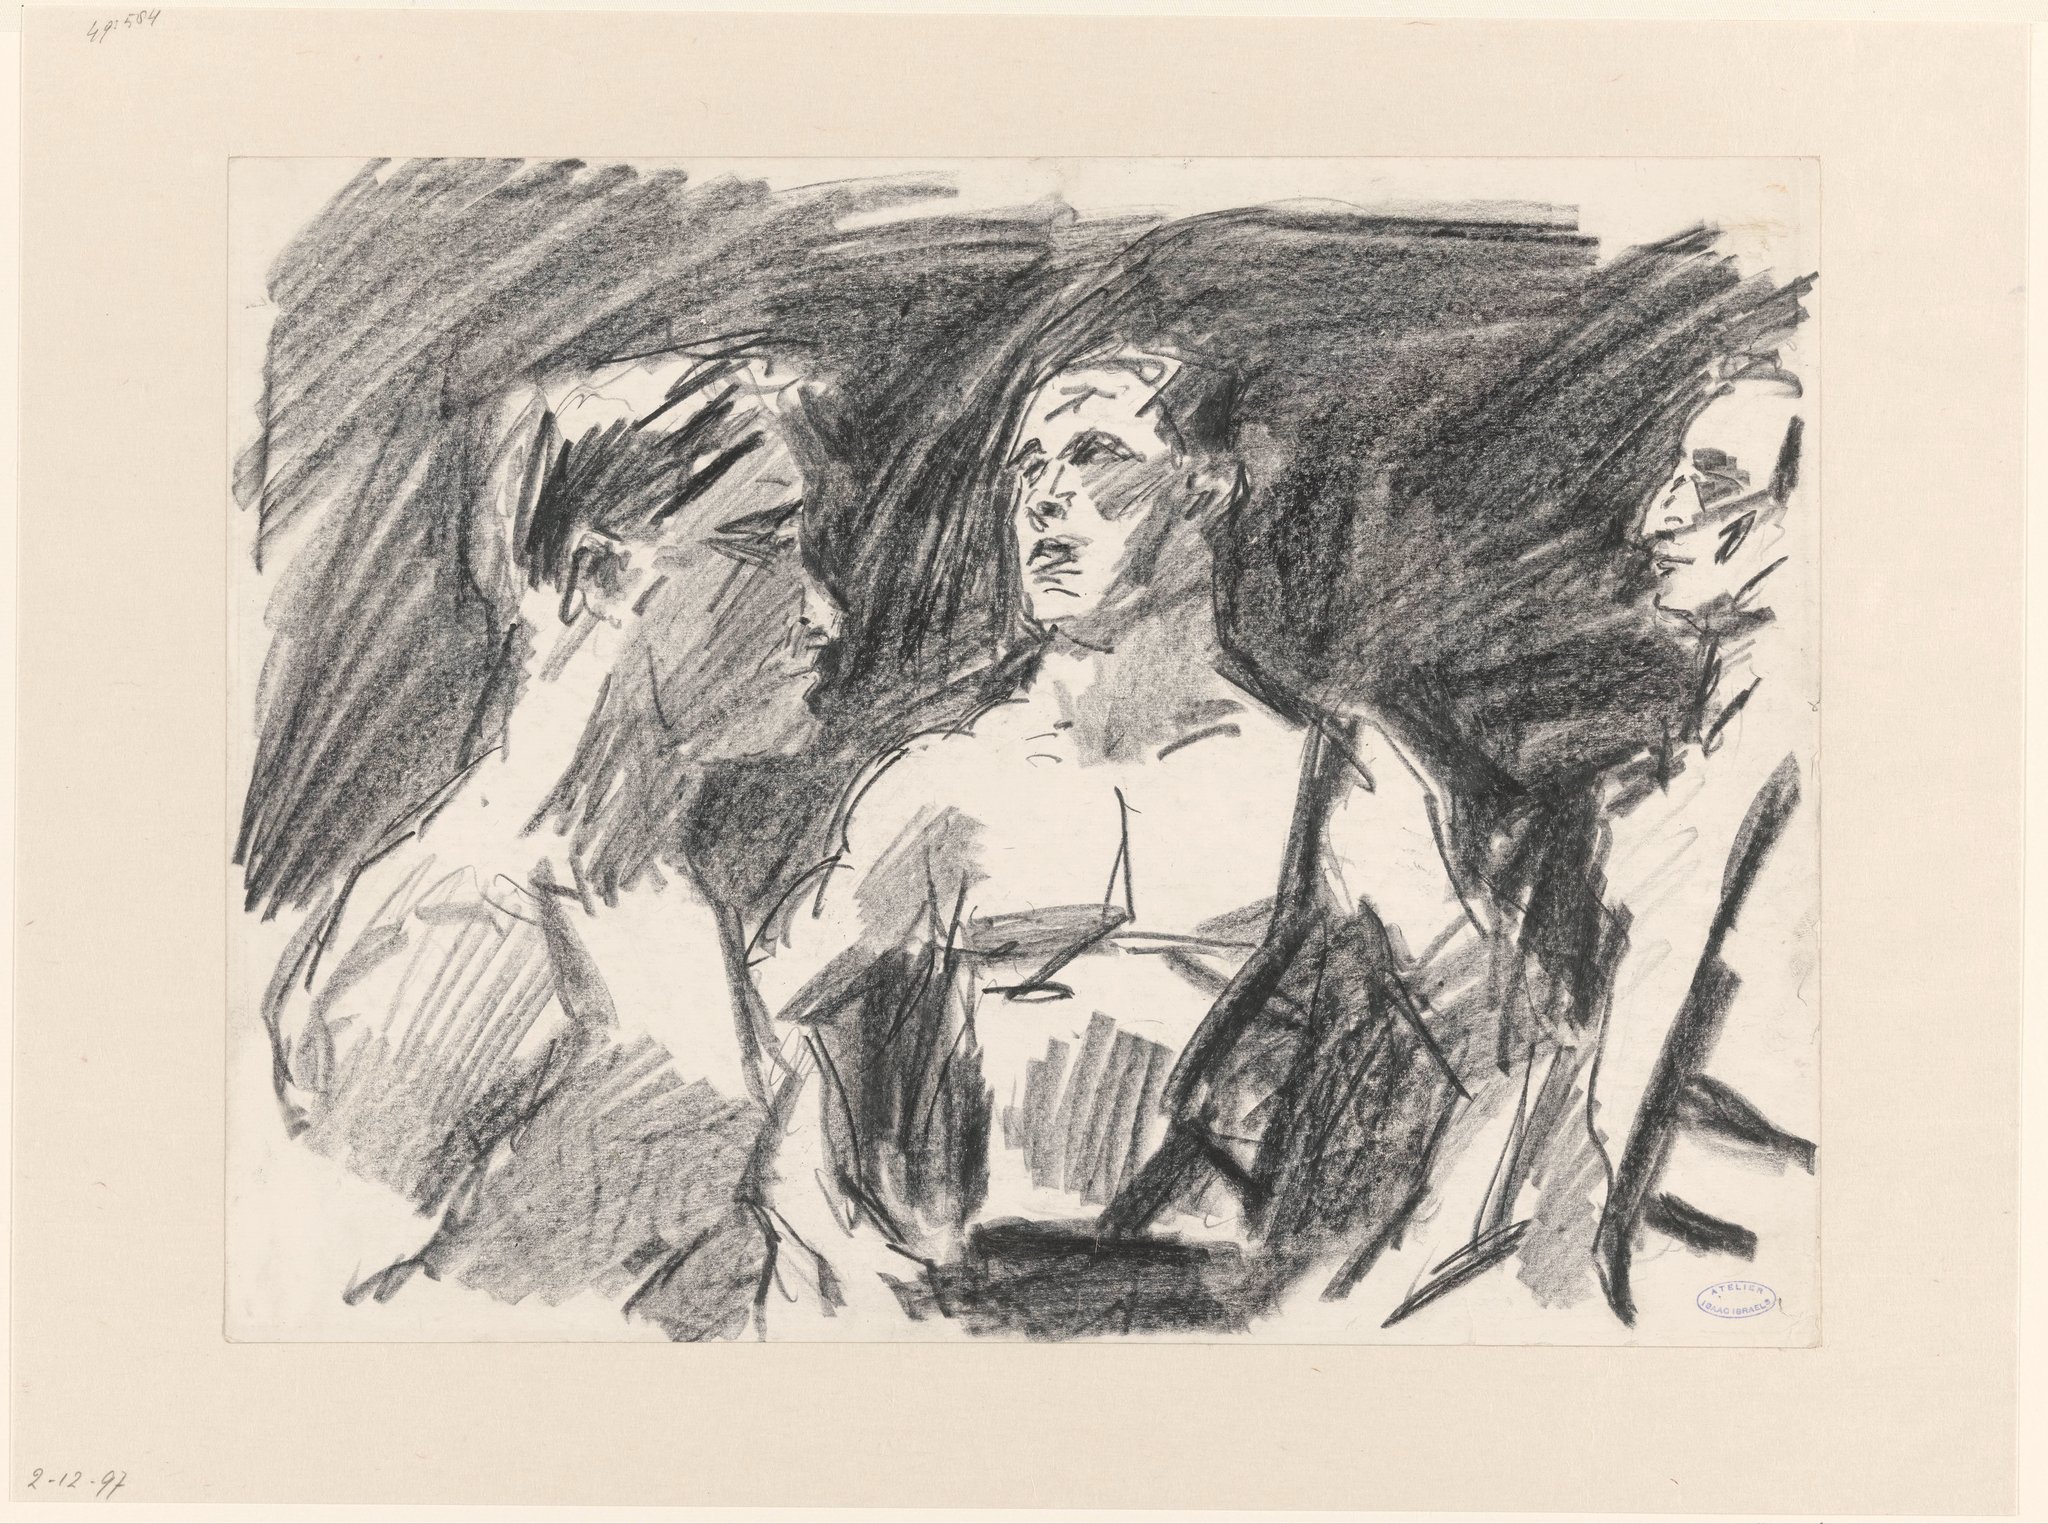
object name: drawing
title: Circusacrobaten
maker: isaac israels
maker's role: draughtsman, painter, print maker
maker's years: 1865-1934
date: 1875-1934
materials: chalk, paper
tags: acrobat ~ circus